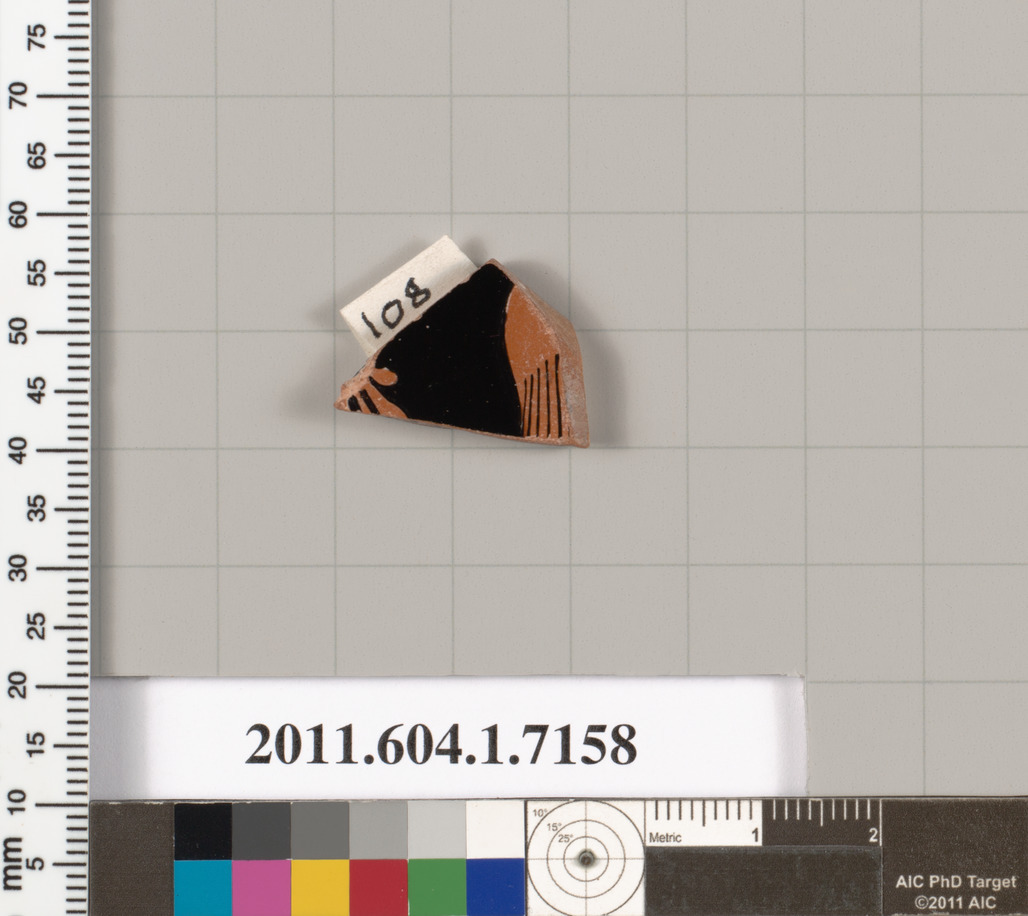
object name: kylix fragment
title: Terracotta fragment of a kylix (drinking cup)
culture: greek, attic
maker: makron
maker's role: artist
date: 500-480 BCE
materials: terracotta